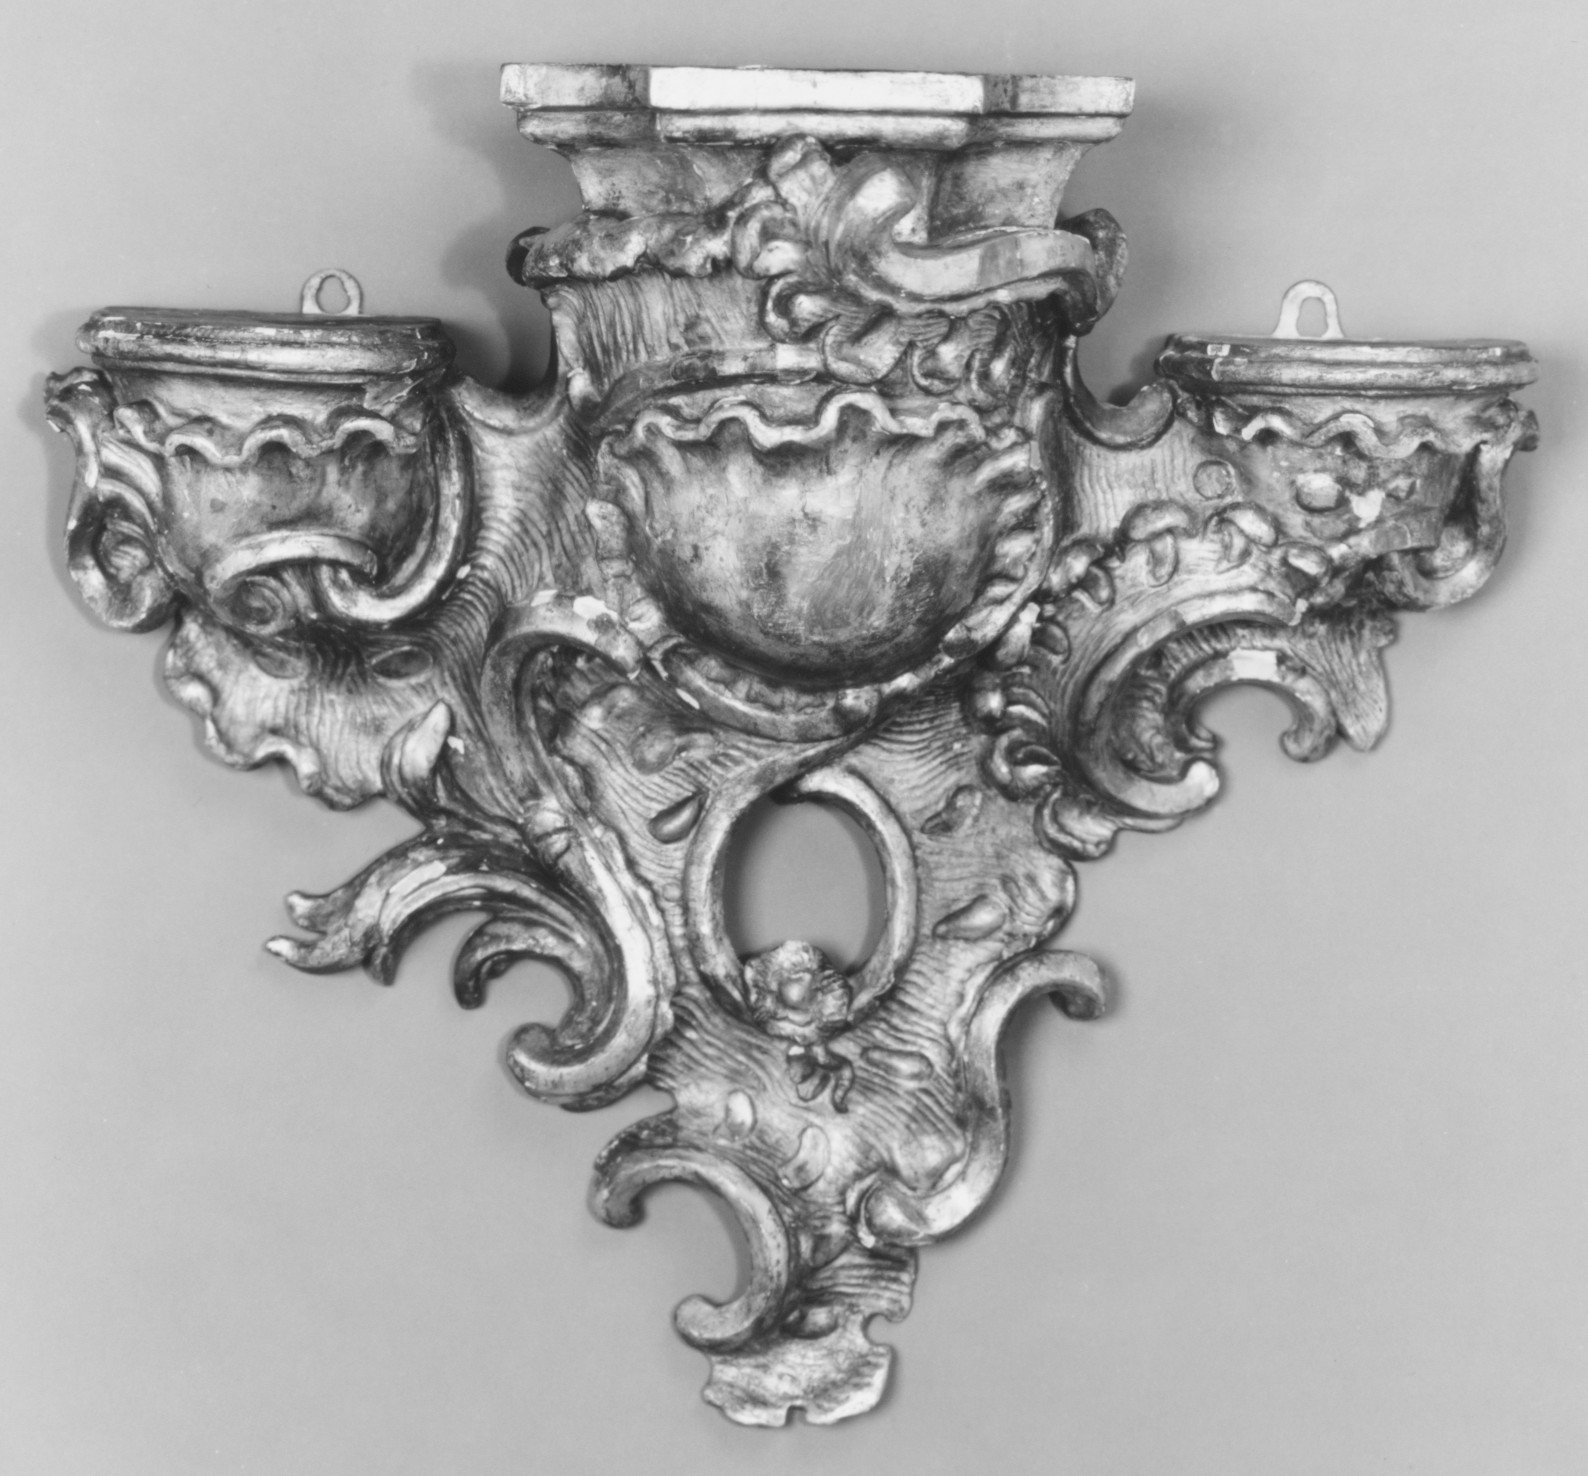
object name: bracket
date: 1750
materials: wood